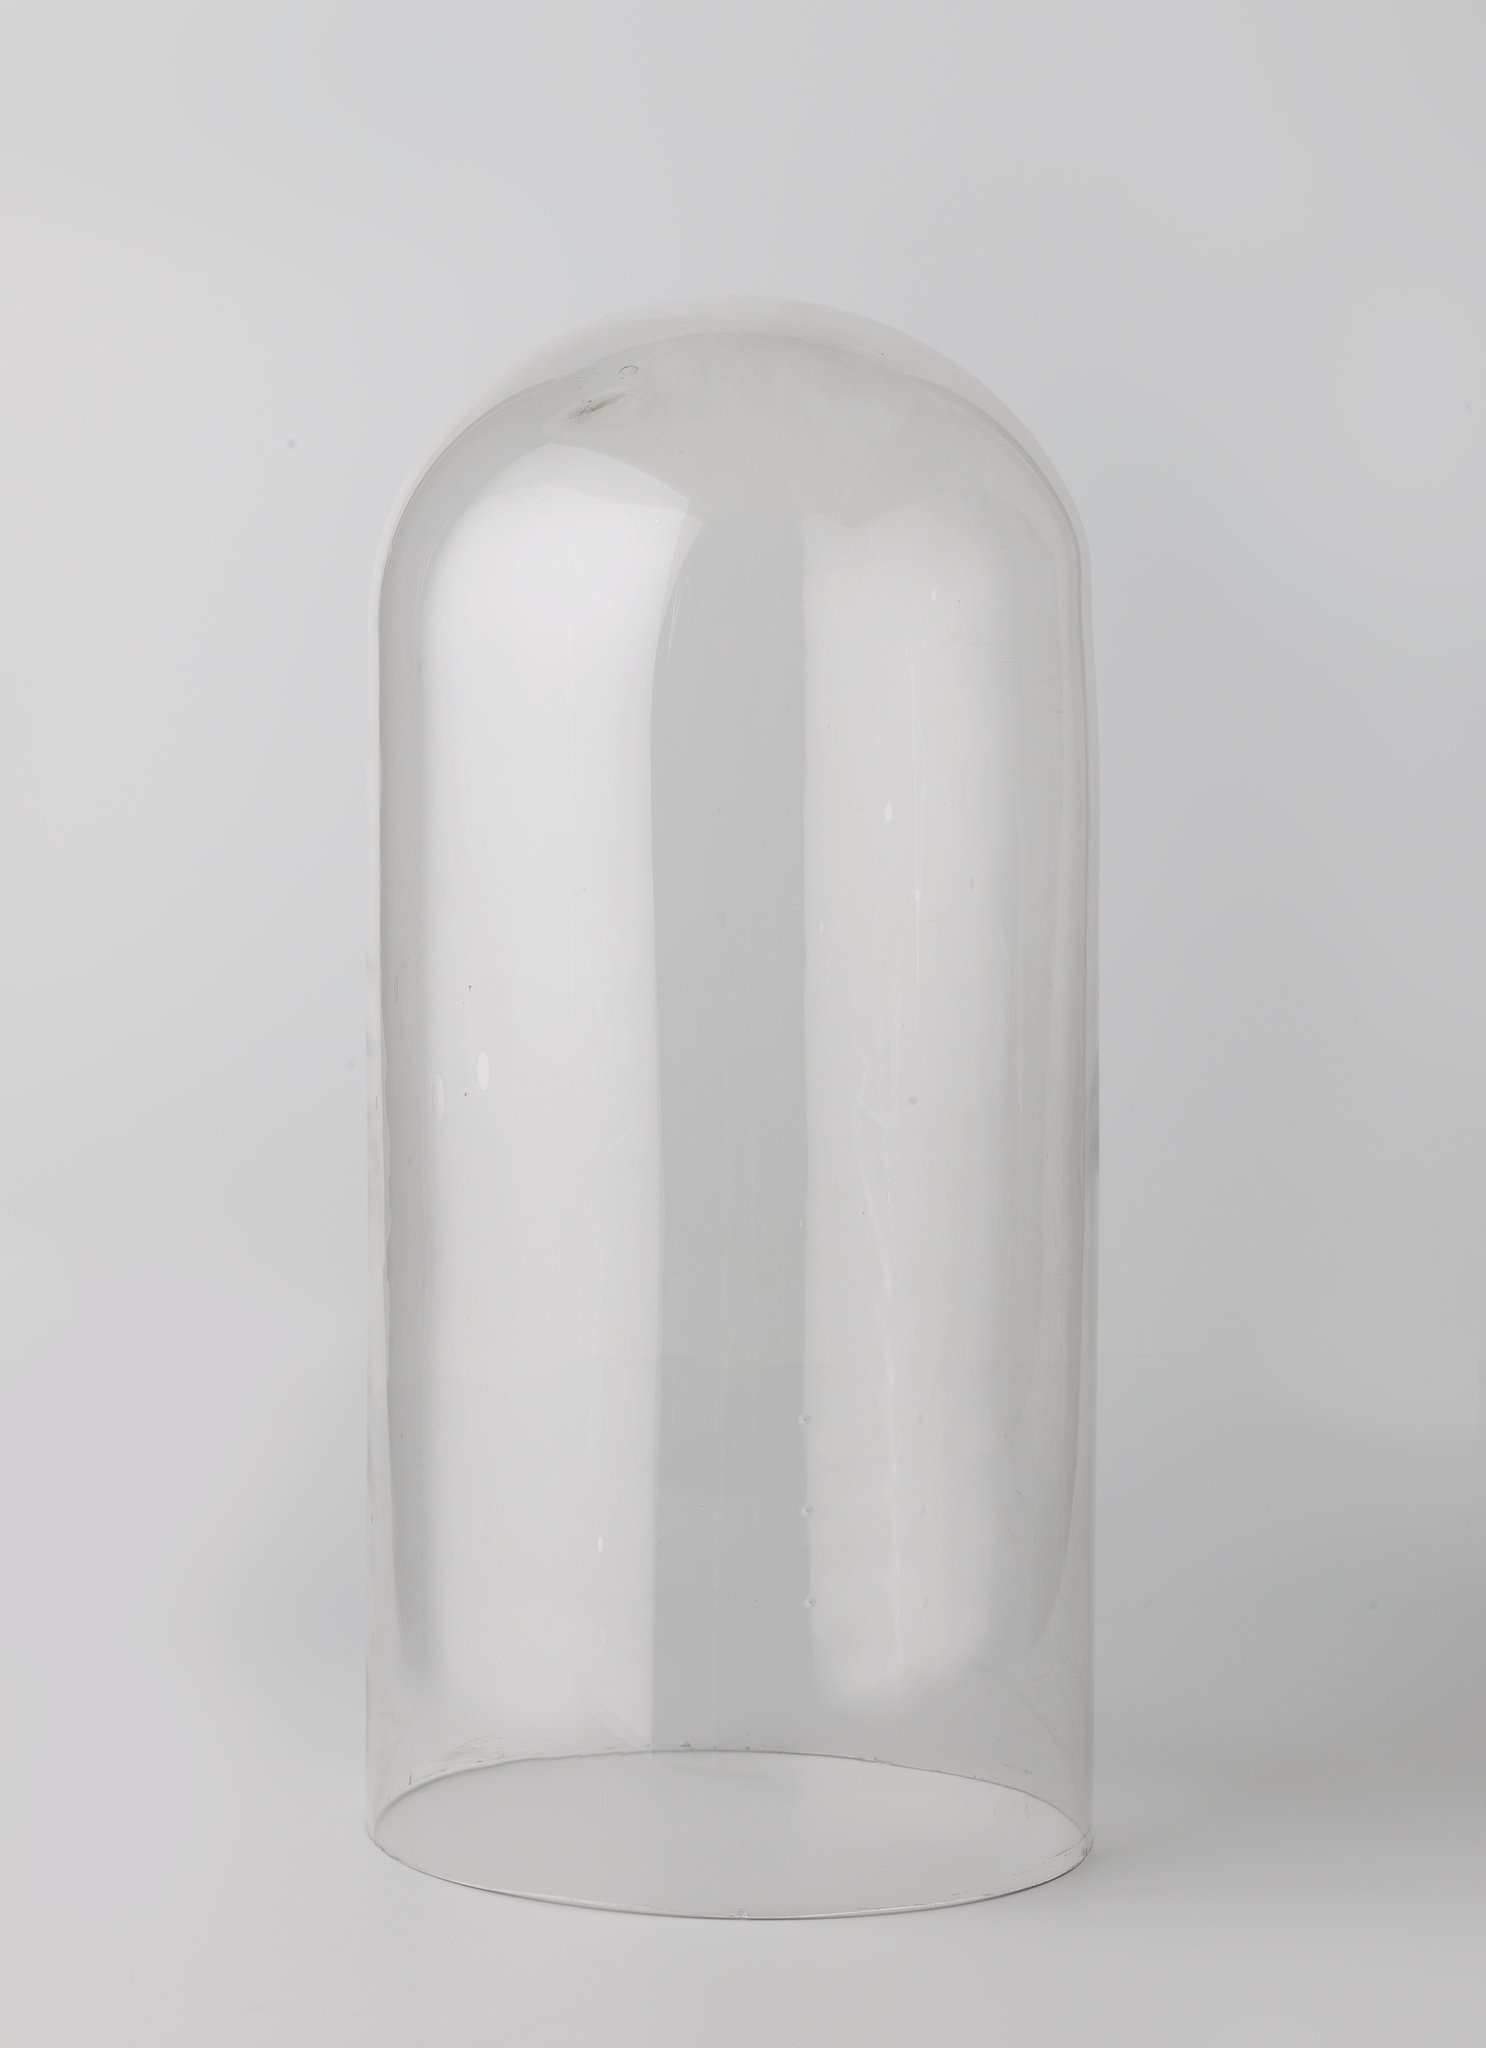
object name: bell jar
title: Glazen stolp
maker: Anonymous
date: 1900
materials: glass